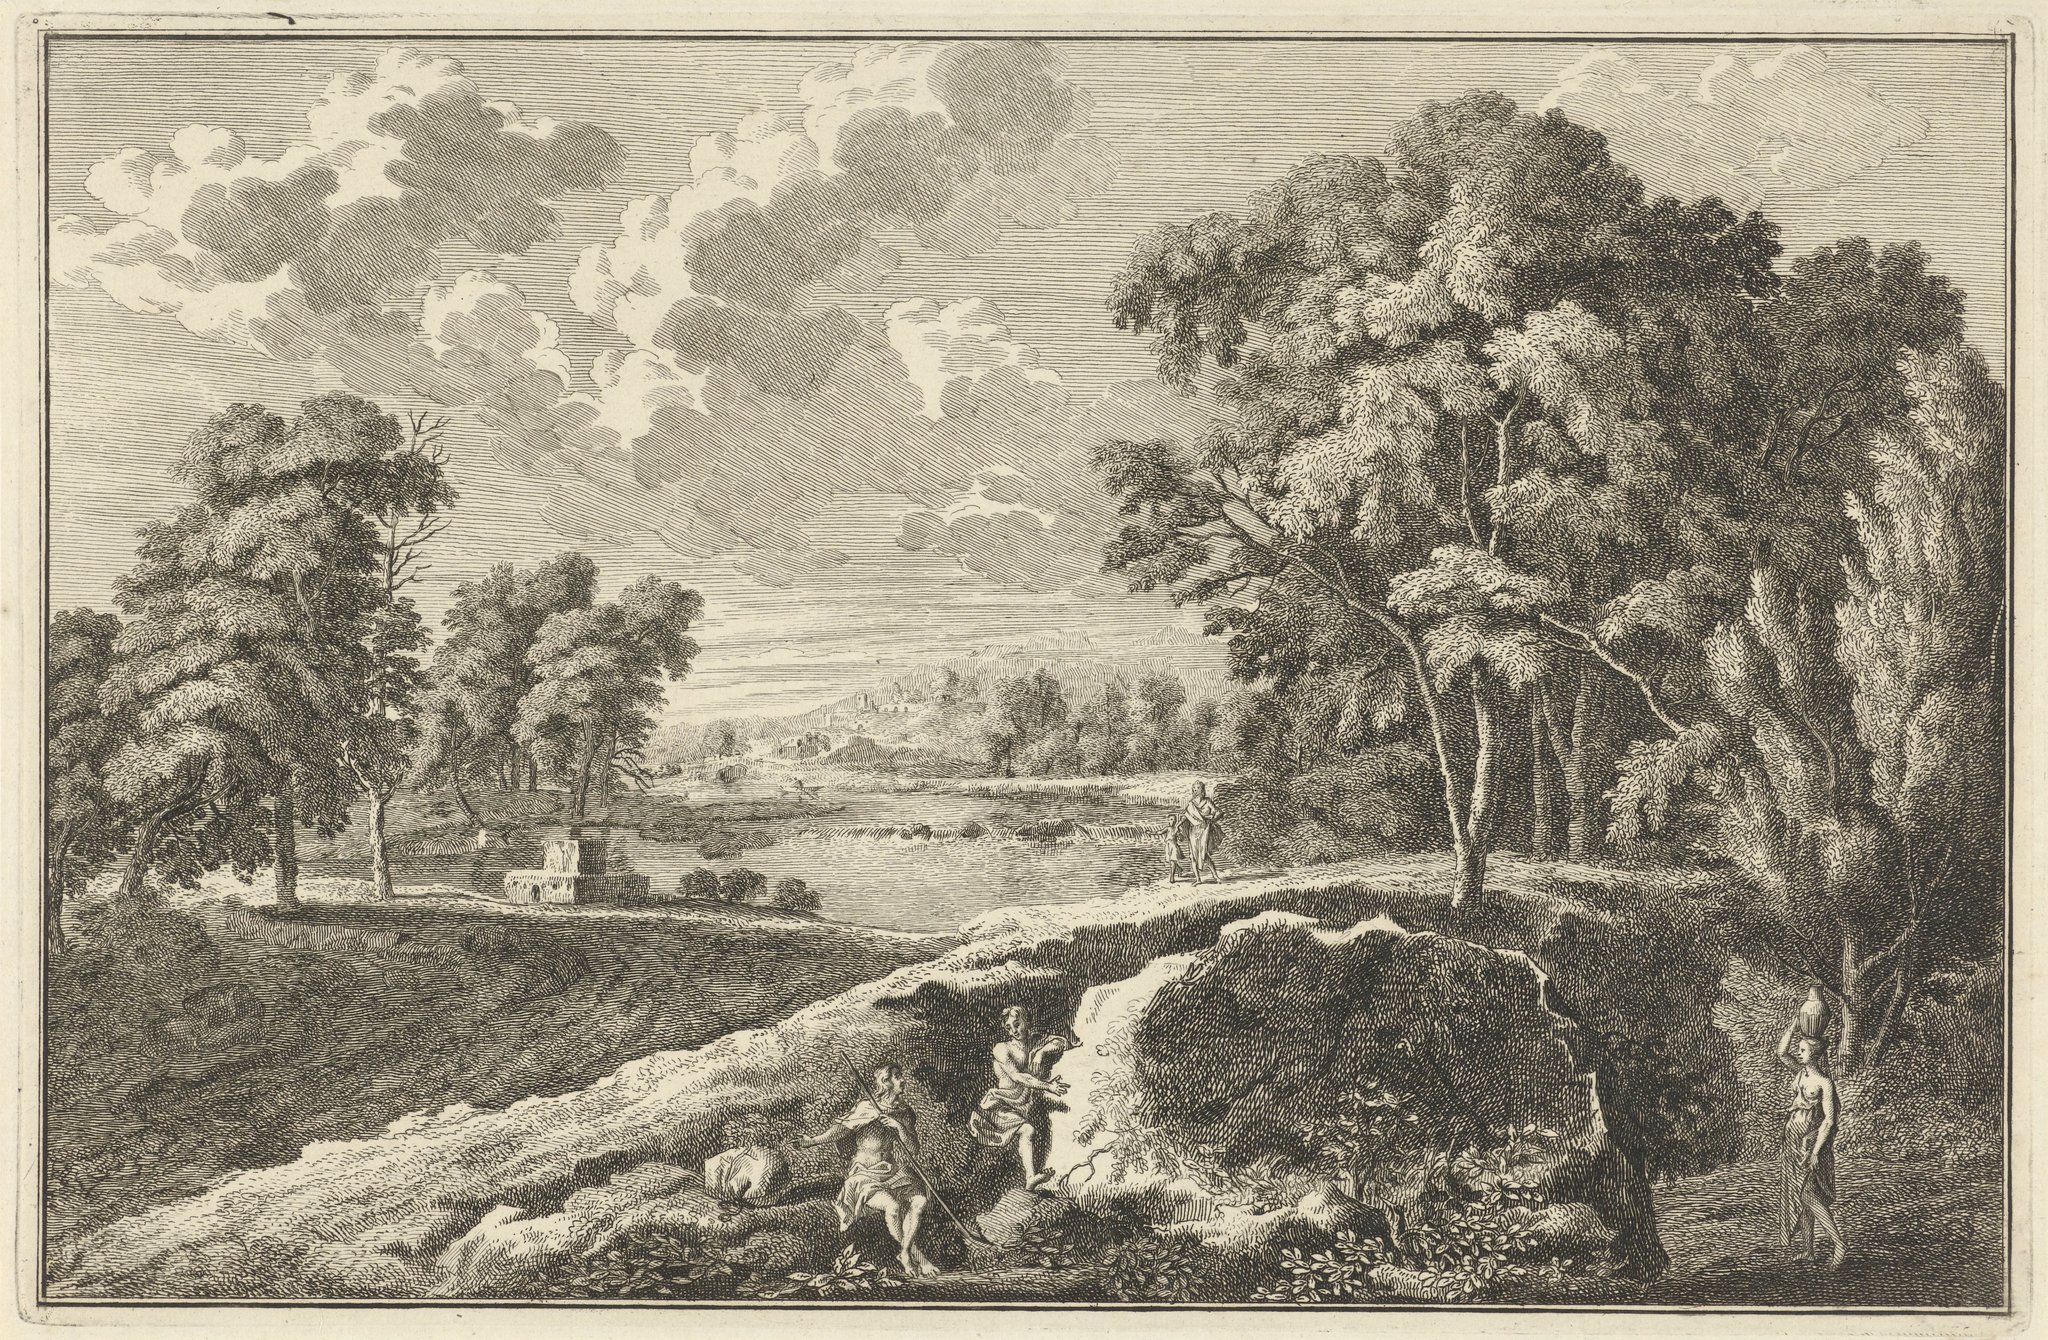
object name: print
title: Arcadisch rivierlandschap met vrouw en kind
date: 1710-1747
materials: paper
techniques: etching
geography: amsterdam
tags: herding, herdsman, herdswoman, shepherd, shepherdess, cowherd, etc., landscapes with waters, waterscapes, seascapes (in the temperate zone)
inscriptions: collector's mark: Lugt 240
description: Arcadisch rivierlandschap met vrouw en kind. Op de voorgrond twee herders en een vrouw met kruik op het hoofd. De prent maakt deel uit van een 40-delige serie prenten met voorstellingen van Italiaanse en Duitse landschappen.